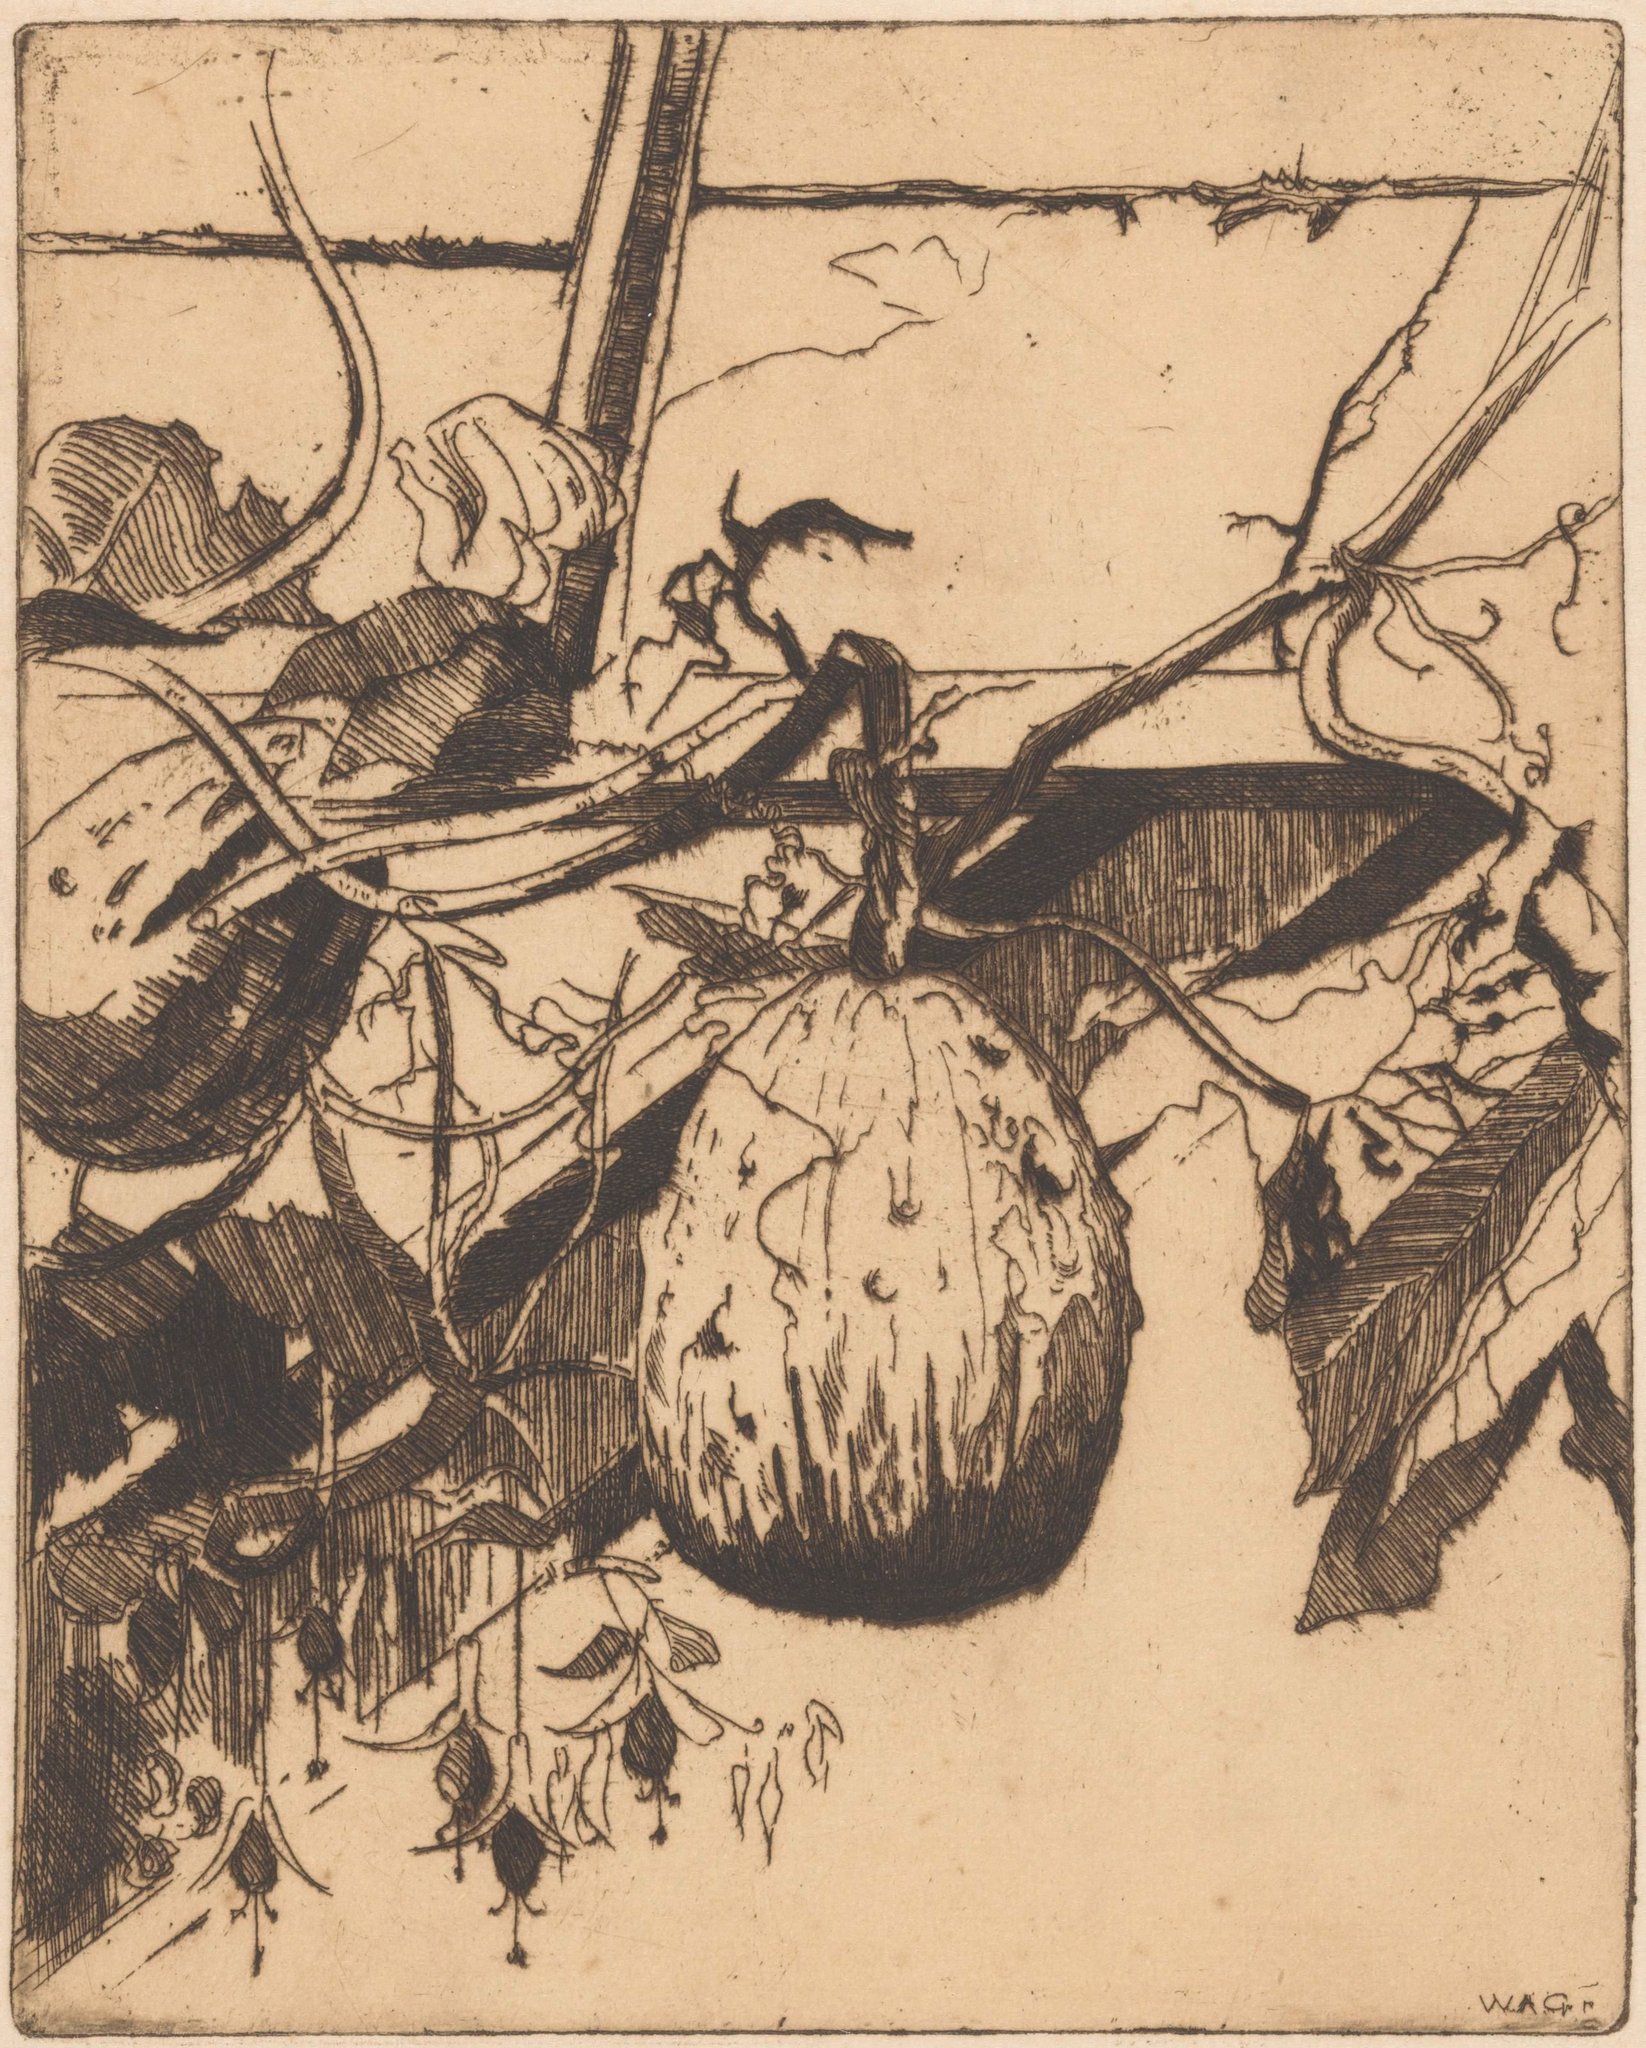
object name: print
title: Kalebassen en fuchsia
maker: willem adrianus grondhout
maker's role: draughtsman, painter, print maker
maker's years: 1878-1934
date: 1888-1934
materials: paper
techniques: etching, intaglio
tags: flowers, fruits: gourd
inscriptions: collector's mark: Lugt 2228